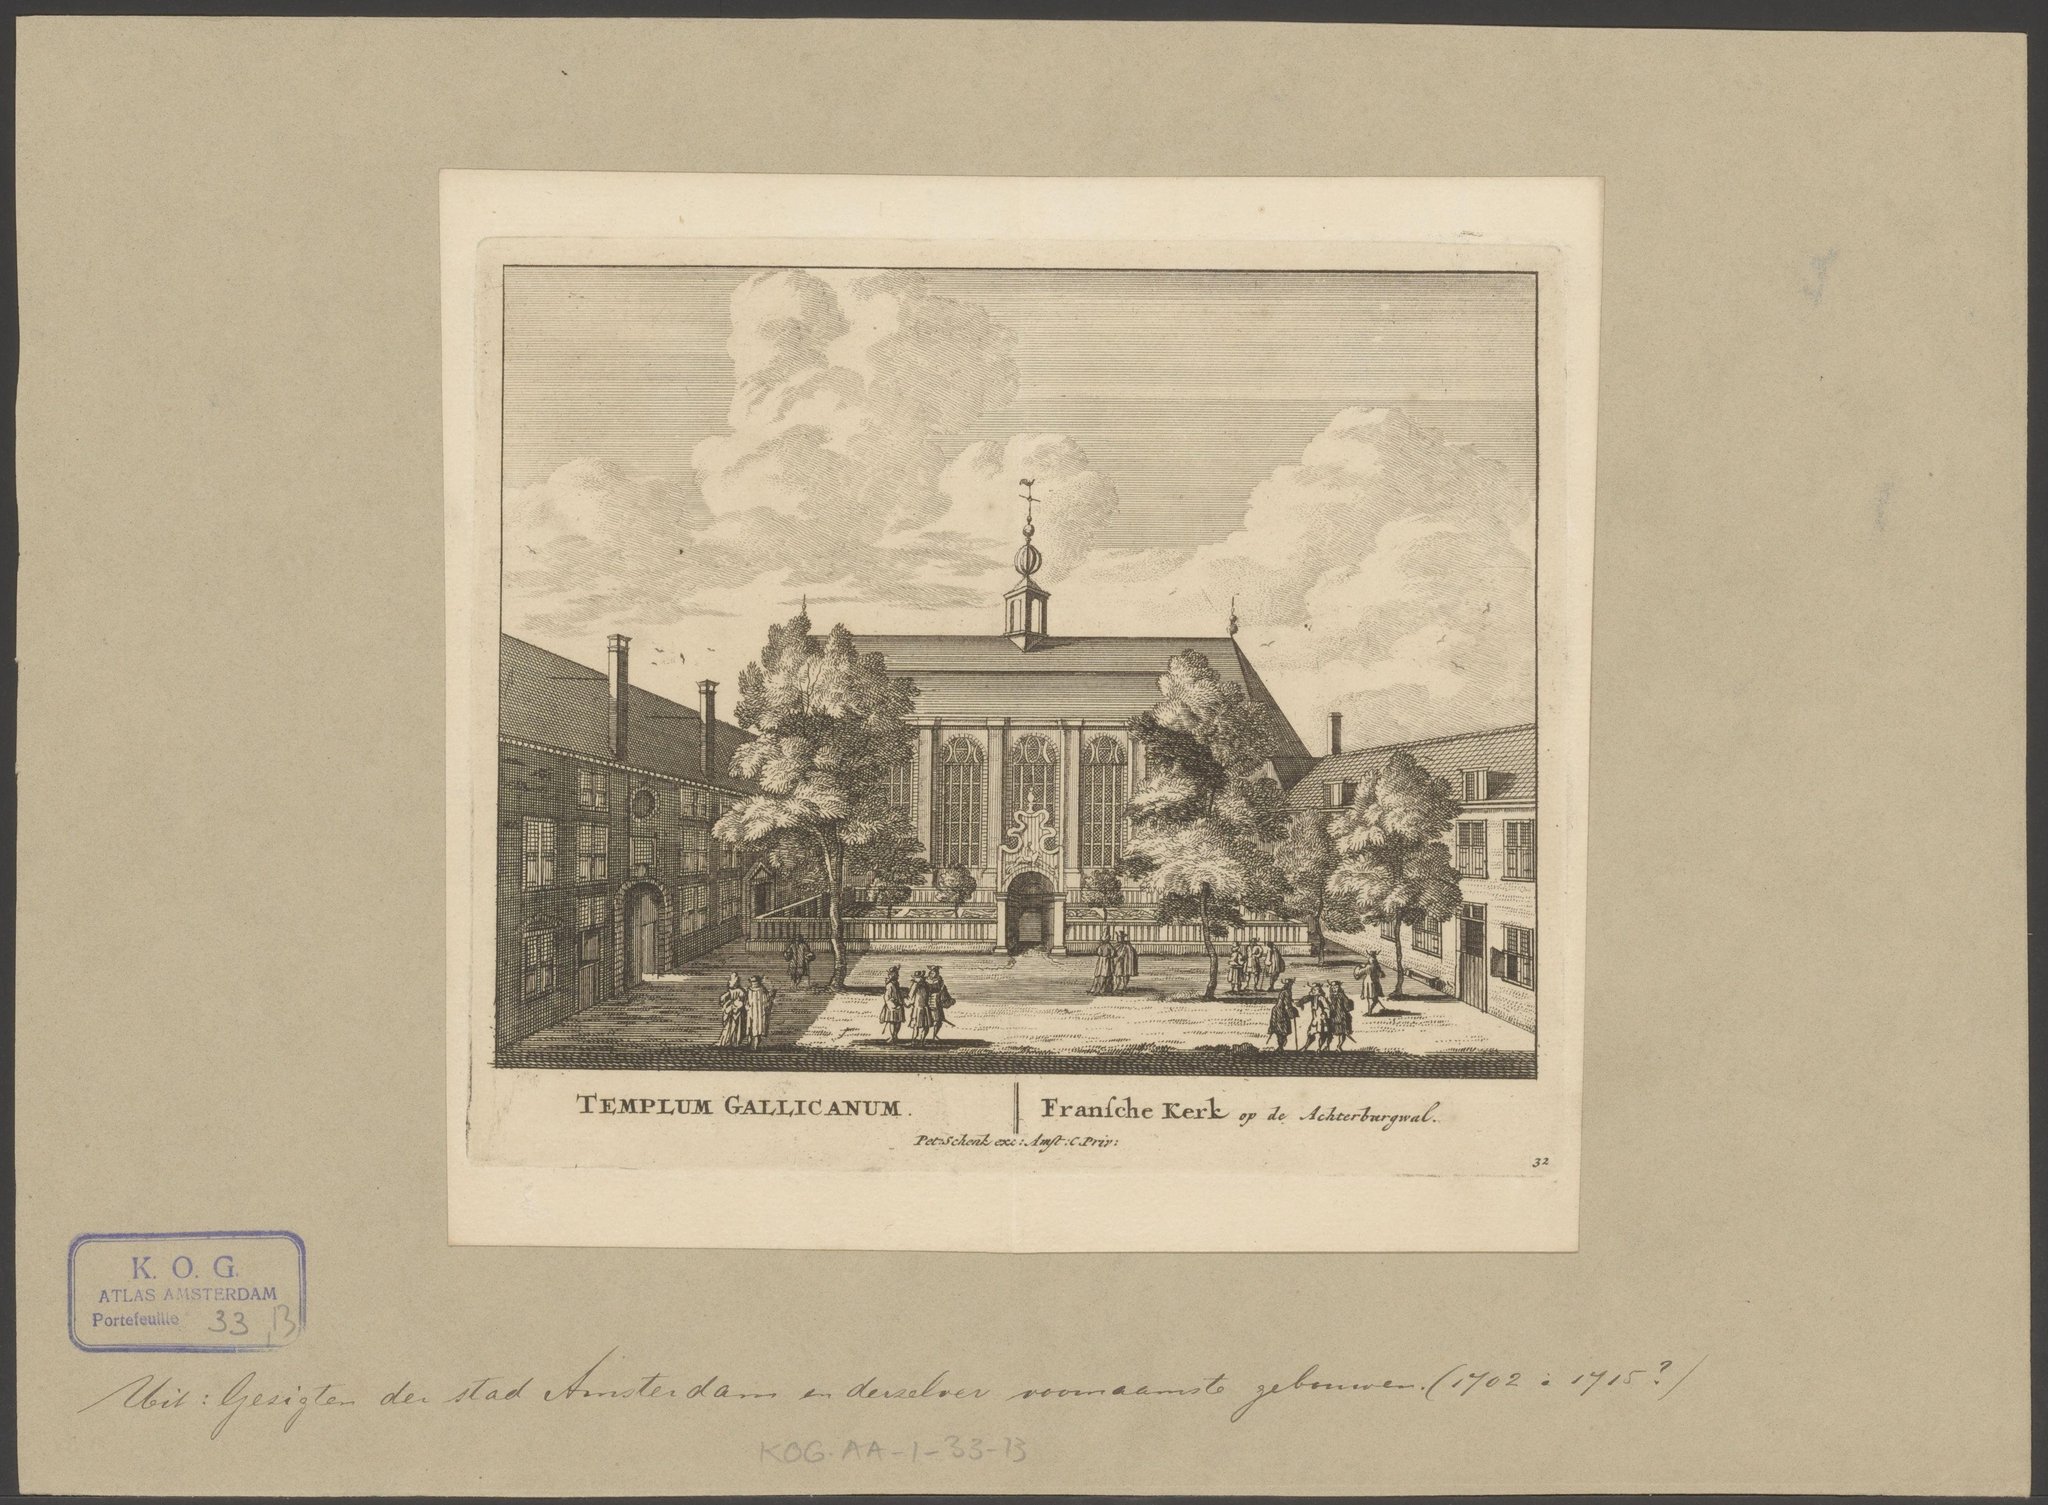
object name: print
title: 100 Afbeeldinge der voornaamste gebouwen van Amsterdam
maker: Anonymous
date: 1710-1711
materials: paper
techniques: engraving, etching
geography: northern netherlands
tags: alms-house (dutch: 'hofje'), church (exterior), square, place, circus, etc. (+ city(-scape) with figures, staffage)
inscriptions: collector's mark: Lugt 1641b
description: Prent mogelijk uit: 100 Afbeeldinge der voornaamste gebouwen van Amsterdam. Amsterdam: Pieter Schenk (I), s.a. [1710-1711]. Of uit: 100 Afbeeldinge der voornaamste gebouwen van Amsterdam. Amsterdam: Barent Greve, s.a. [1757-1766]. In de tweede uitgave, uitgegeven door Barent Greve, is alleen de titelprent aangepast. De overige prenten zijn onveranderd gebleven.